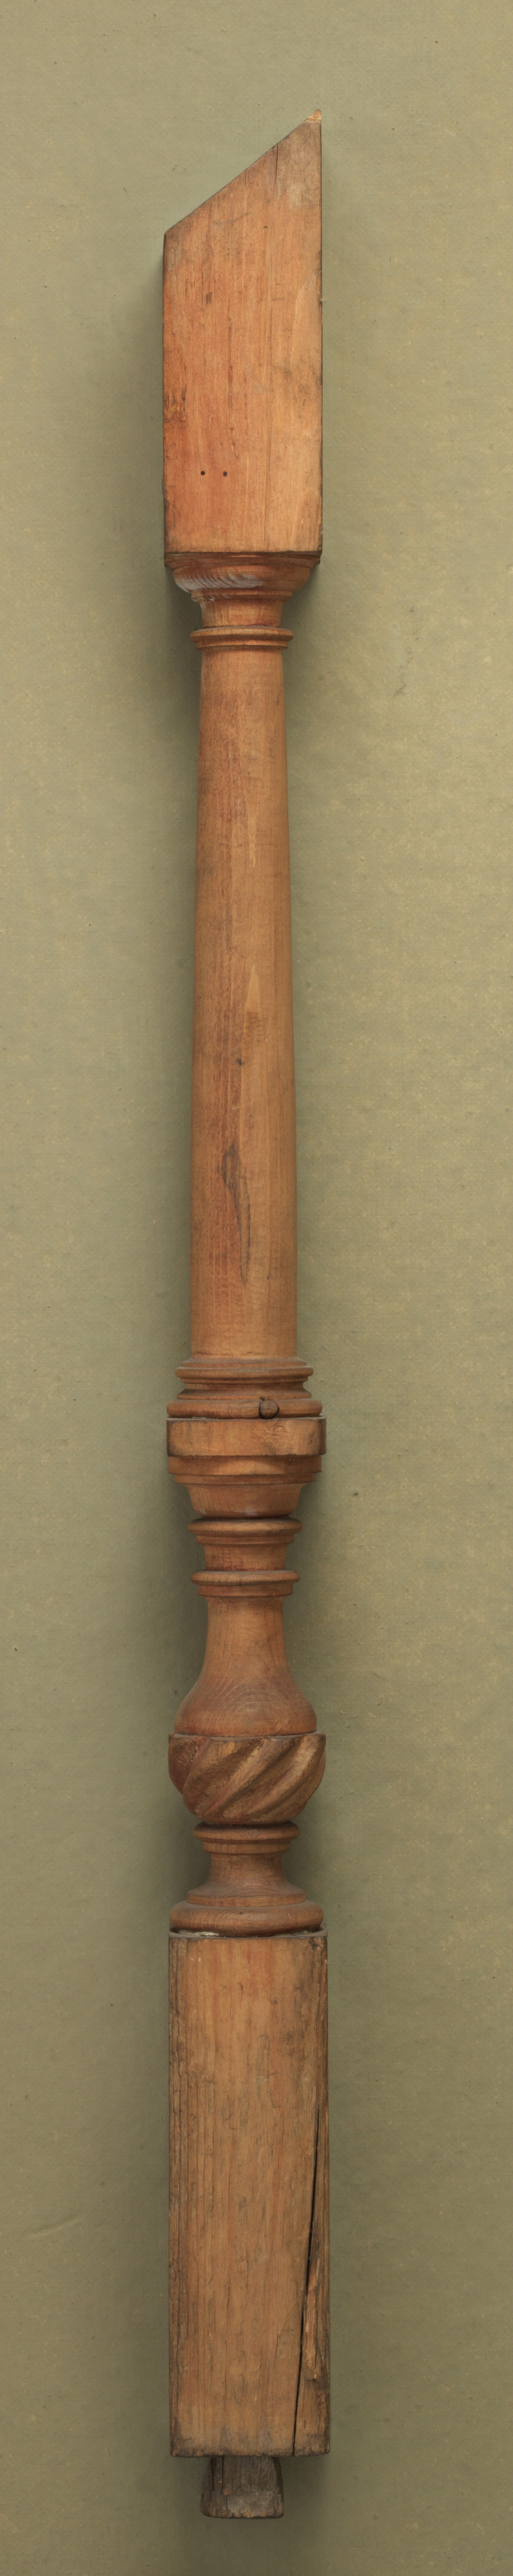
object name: baluster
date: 1734-1766